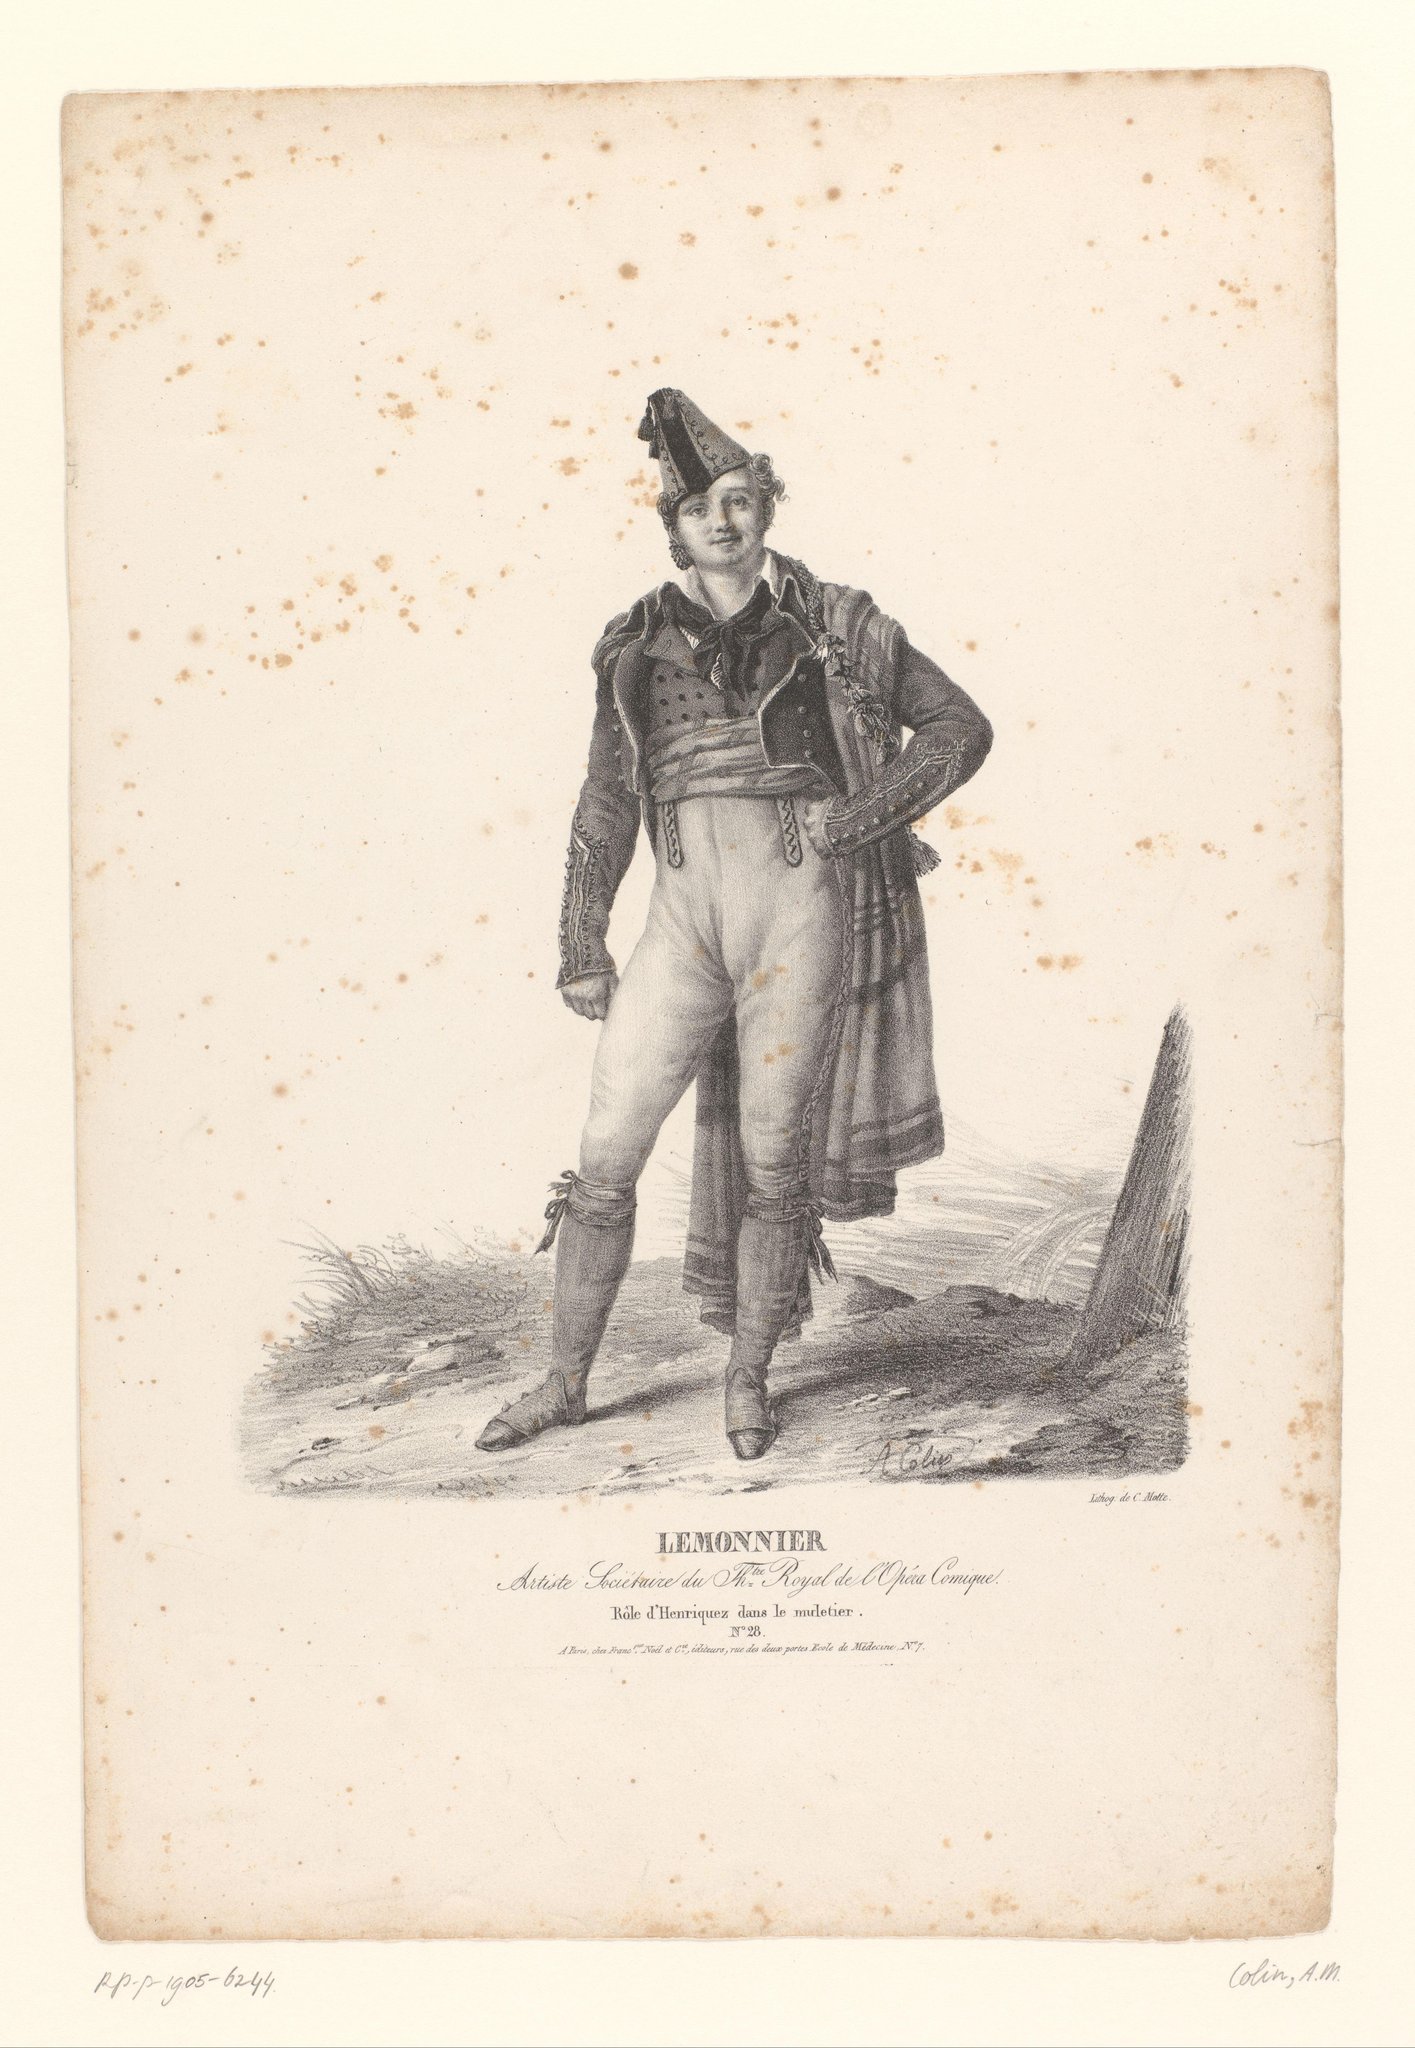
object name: print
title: Portretten van acteurs van Parijse theaters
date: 1824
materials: paper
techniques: lithograph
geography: paris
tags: paris, stage costume, portrait of actor, actress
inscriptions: collector's mark: Lugt 2228a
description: Henriquez is een personage uit de opéra-comique 'Le muletier', geschreven naar het gelijknamige verhaal van Jean de La Fontaine uit 1762 (librettist: Paul de Kock, componist: M. F. Hérold). Opgevoerd door het Théâtre Royal de l'Opéra-Comique in Parijs in 1823.